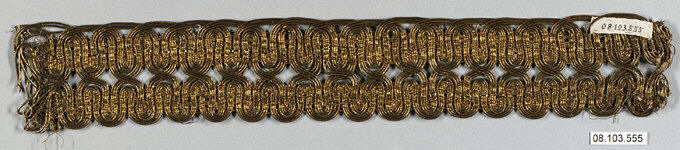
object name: galloon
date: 1701-1800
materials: metal thread